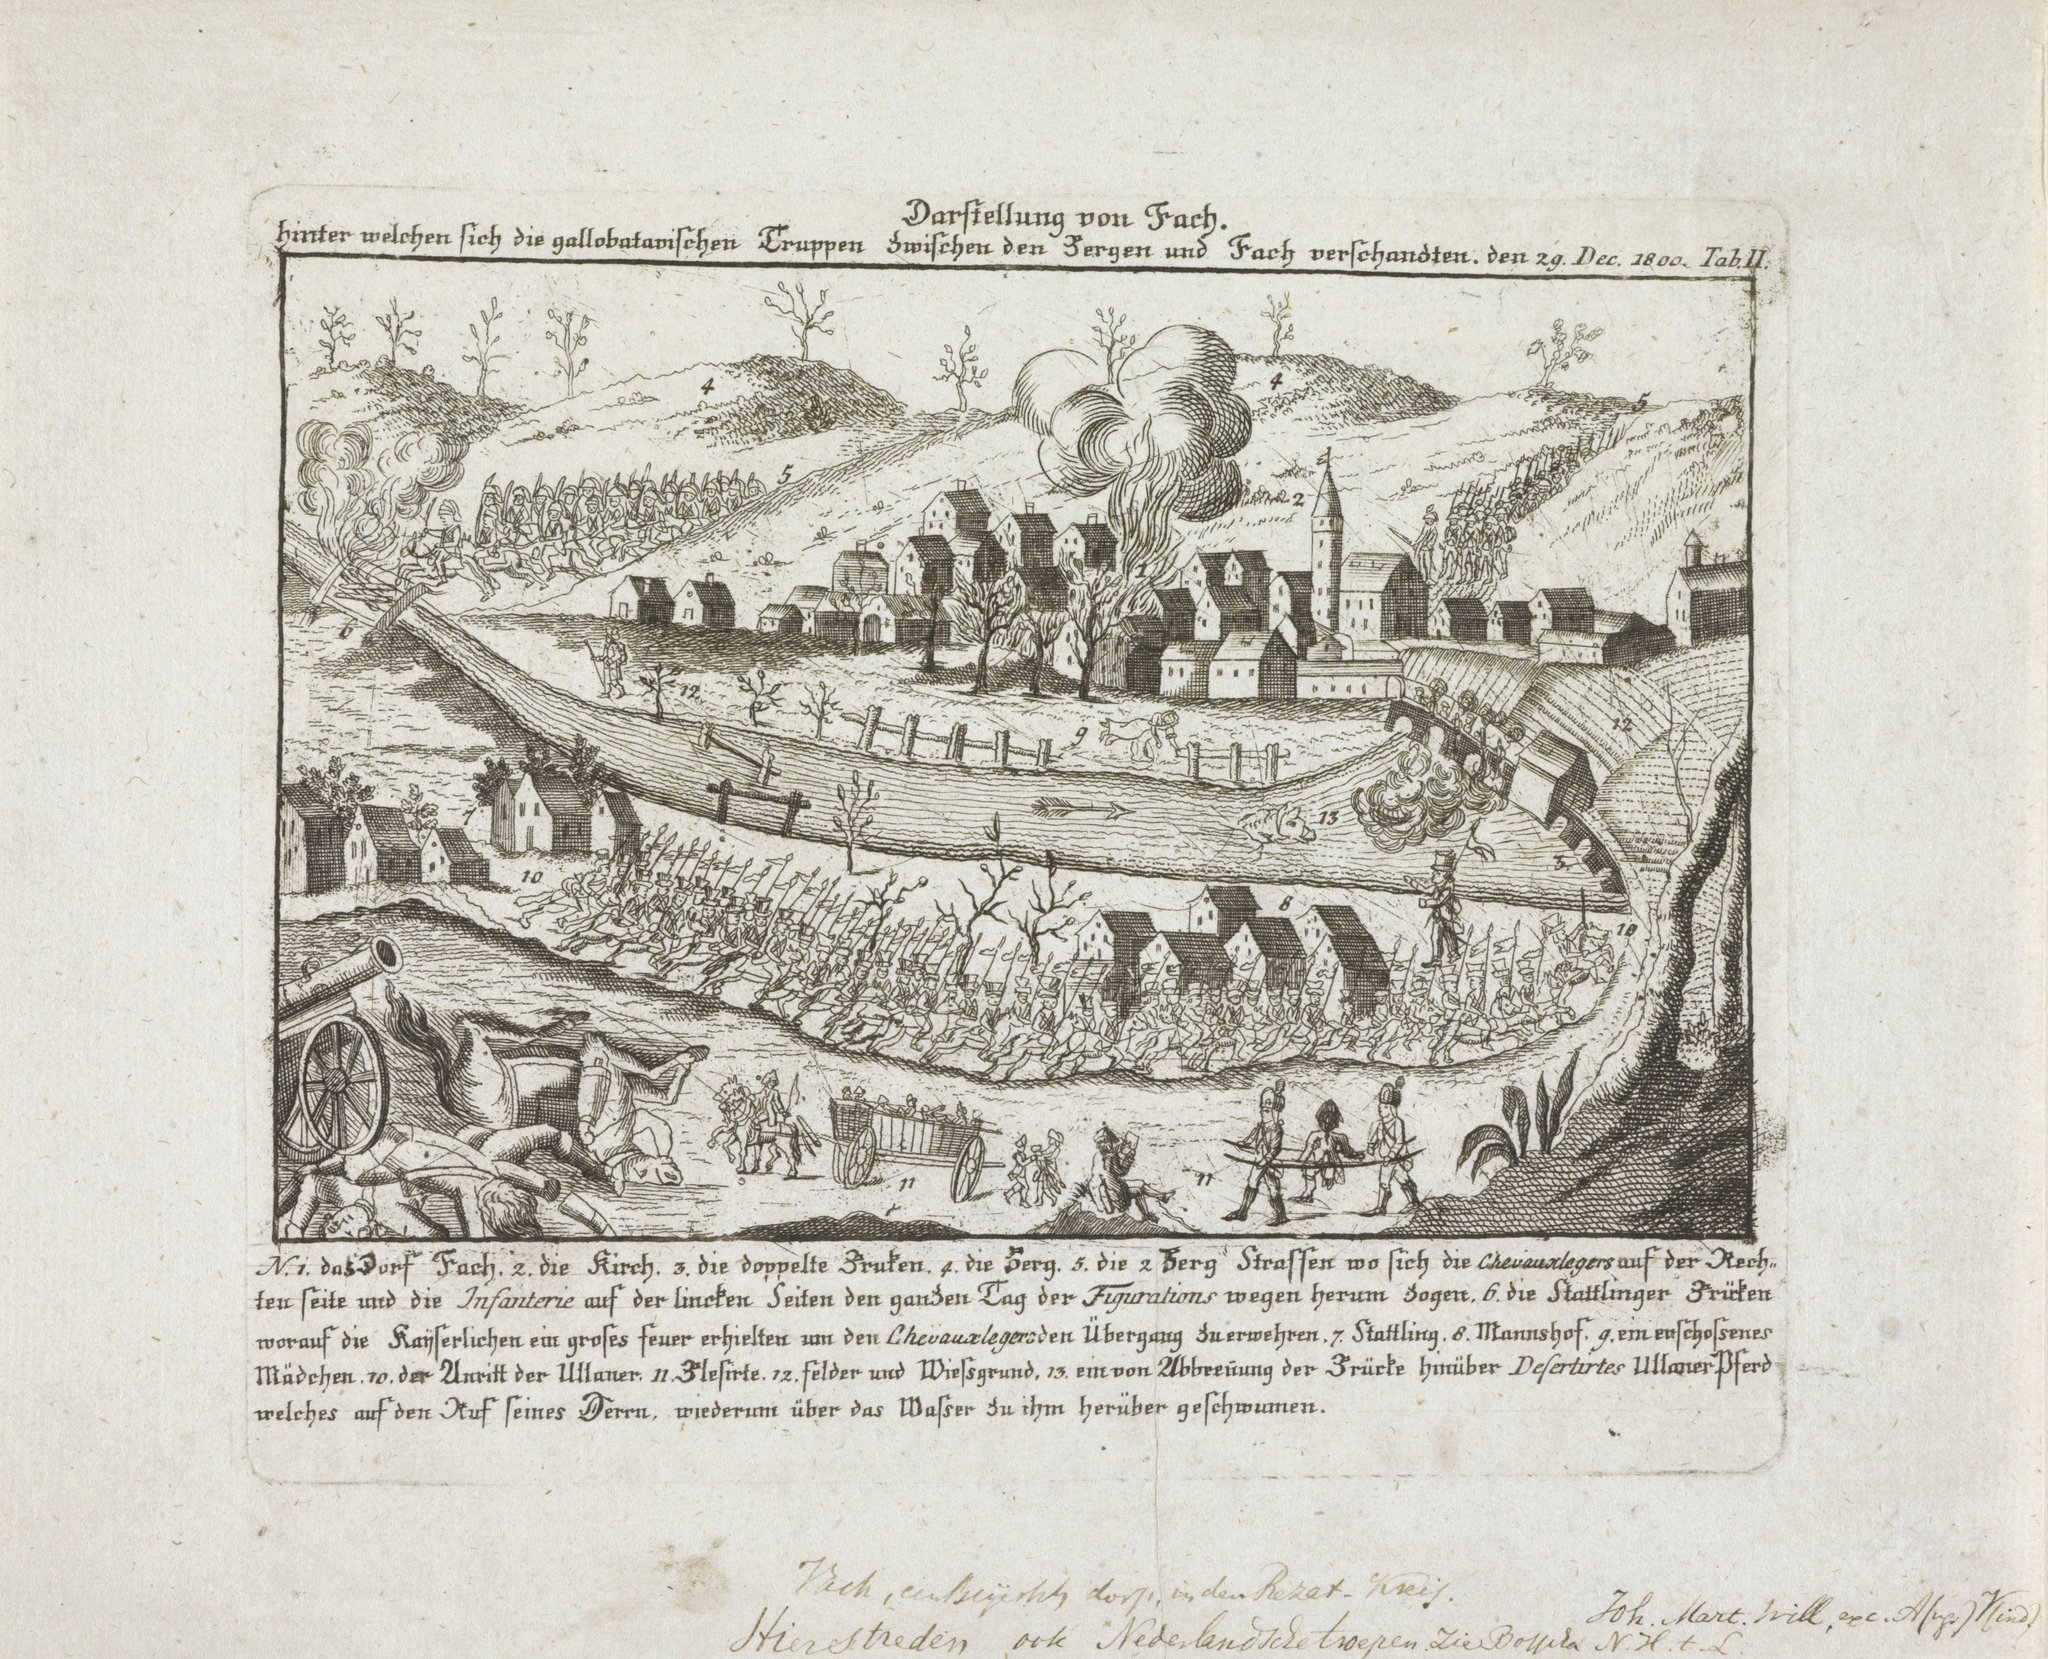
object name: print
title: Strijd bij Vach, 1800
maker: Anonymous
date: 1800-1802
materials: paper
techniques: engraving, etching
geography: germany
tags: battle (+ land forces)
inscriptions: collector's mark: Lugt 2228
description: Gezicht op de strijd bij het Duitse dorp Vach (bij Fürth in Beieren) of Vacha (in Thüringen) waar Frans-Bataafse troepen zich verschansen en waartoe een Duits regiment Ulanen toegang trachten te krijgen, 29 december 1800. In de marge de legenda 1-13 in het Duits. Genummerd rechtsboven: Tab. II.